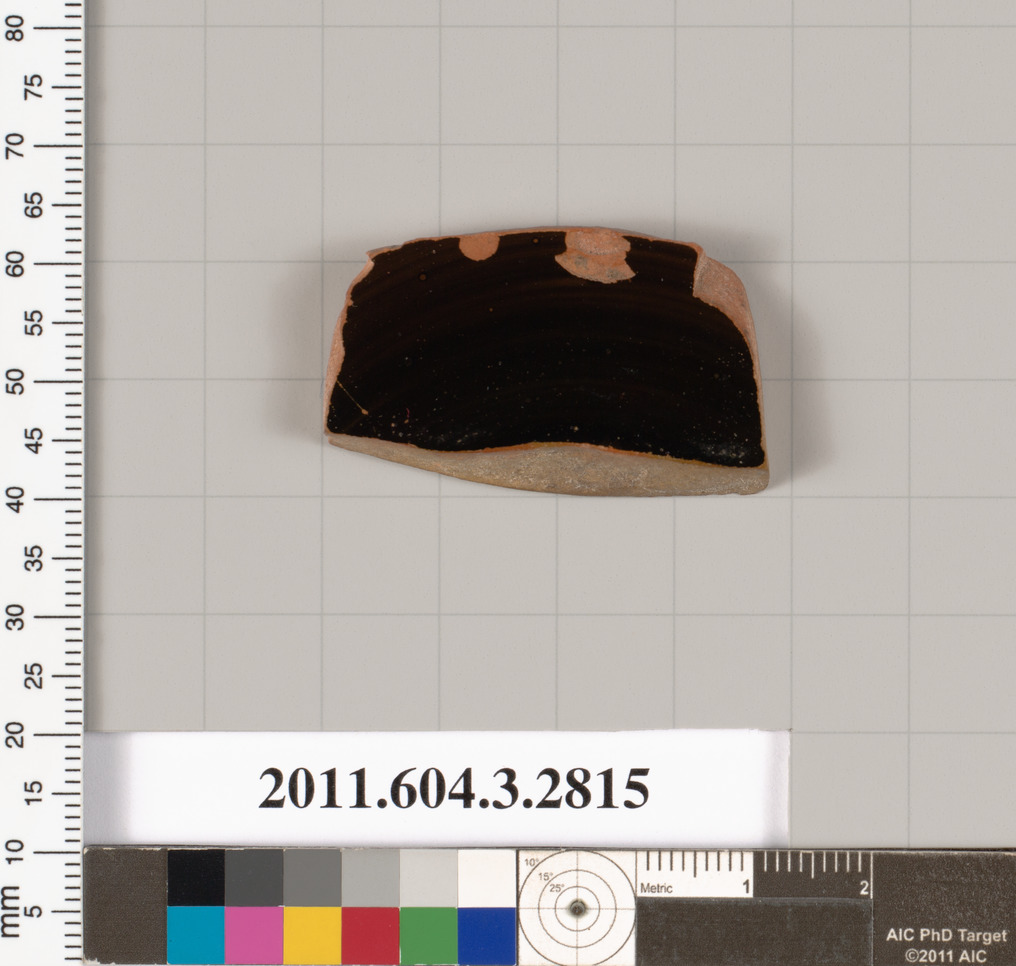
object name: lid fragment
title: Terracotta fragment of a lid?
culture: greek, attic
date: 600-401 BCE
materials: terracotta